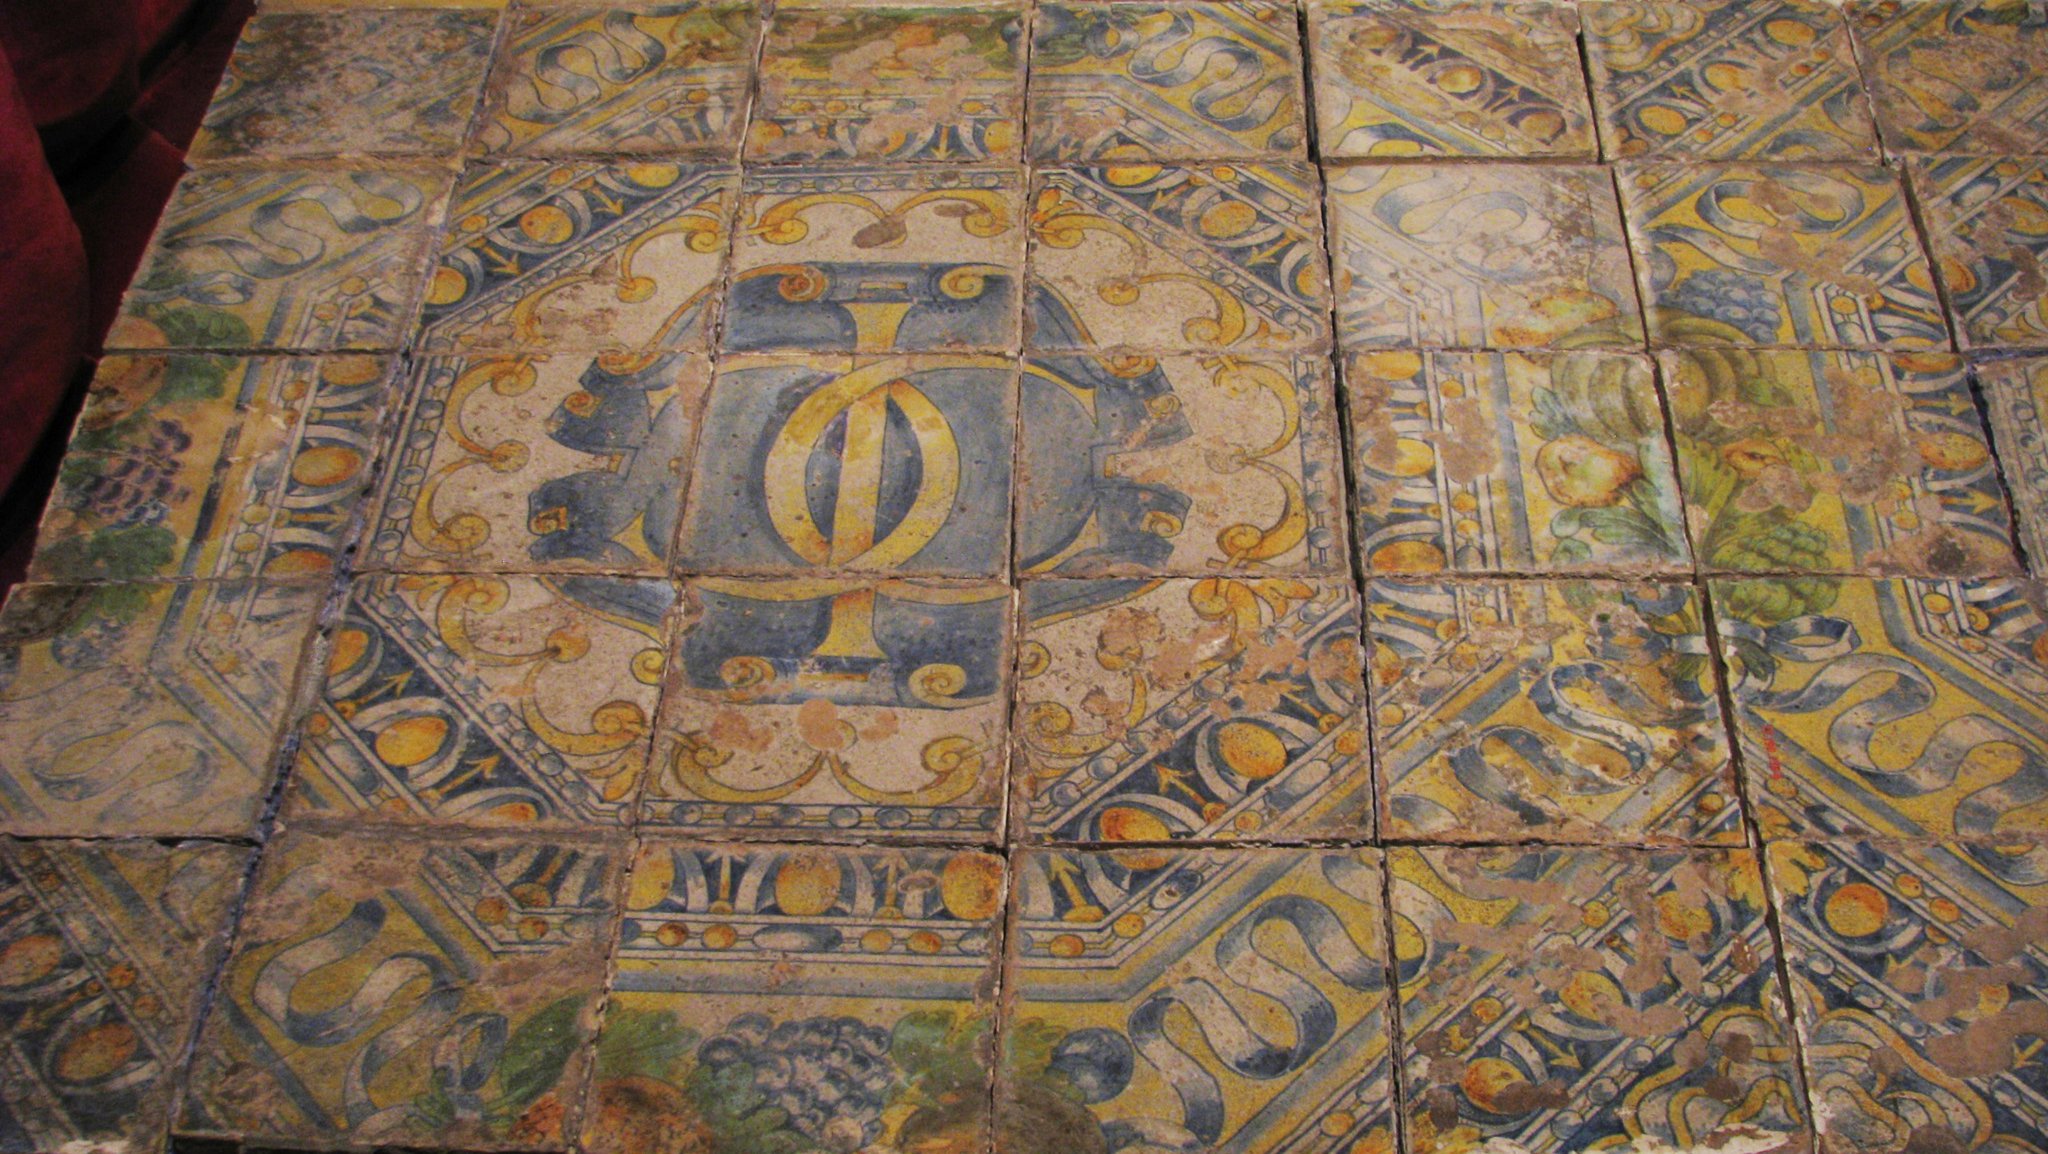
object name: tile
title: Tiles with the devices of Claude d'Urfé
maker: masséot abaquesne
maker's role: maker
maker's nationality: french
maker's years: 1538-1557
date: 1557-1560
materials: faience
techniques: glazing